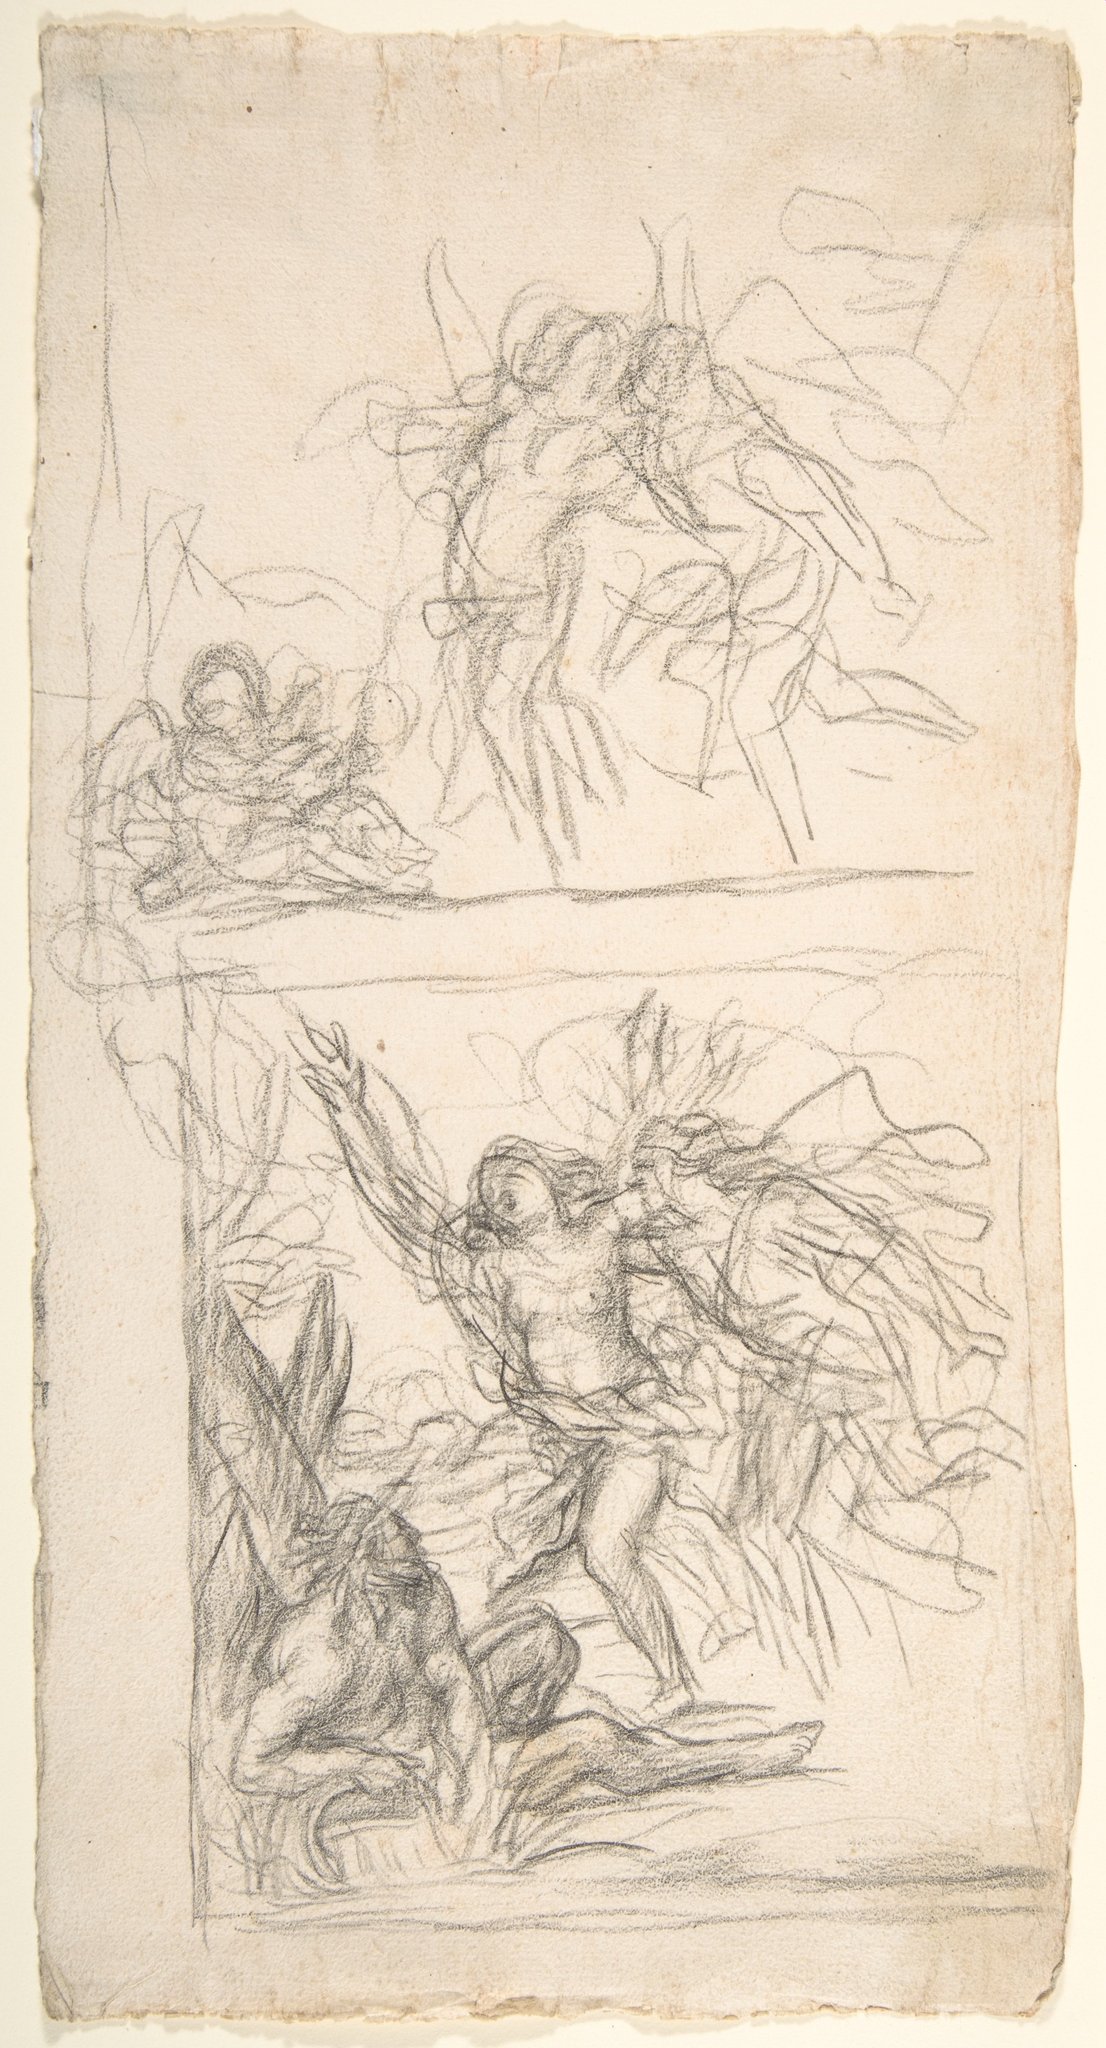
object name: drawing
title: Sheet of Studies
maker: anonymous, italian, 17th century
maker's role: artist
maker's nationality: italian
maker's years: 1600-1700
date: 1601-1700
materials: chalk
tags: men,female nudes